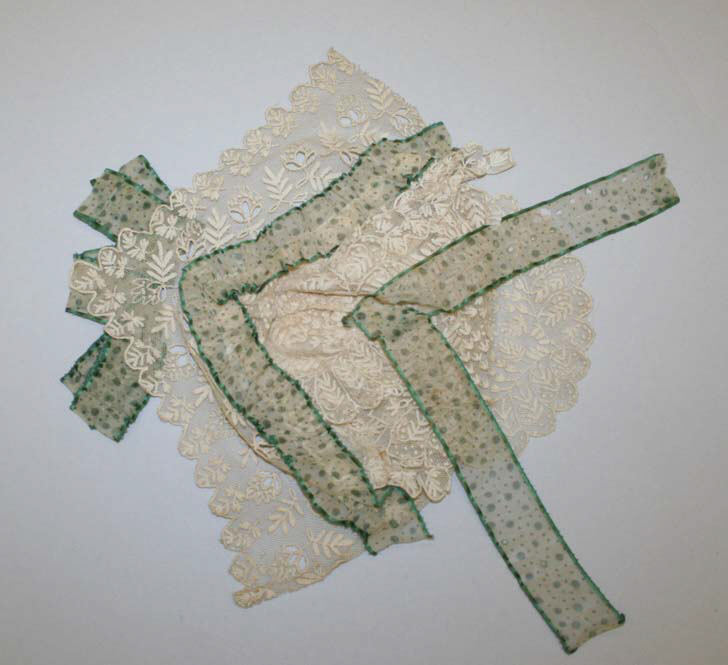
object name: cap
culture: american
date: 1860-1869